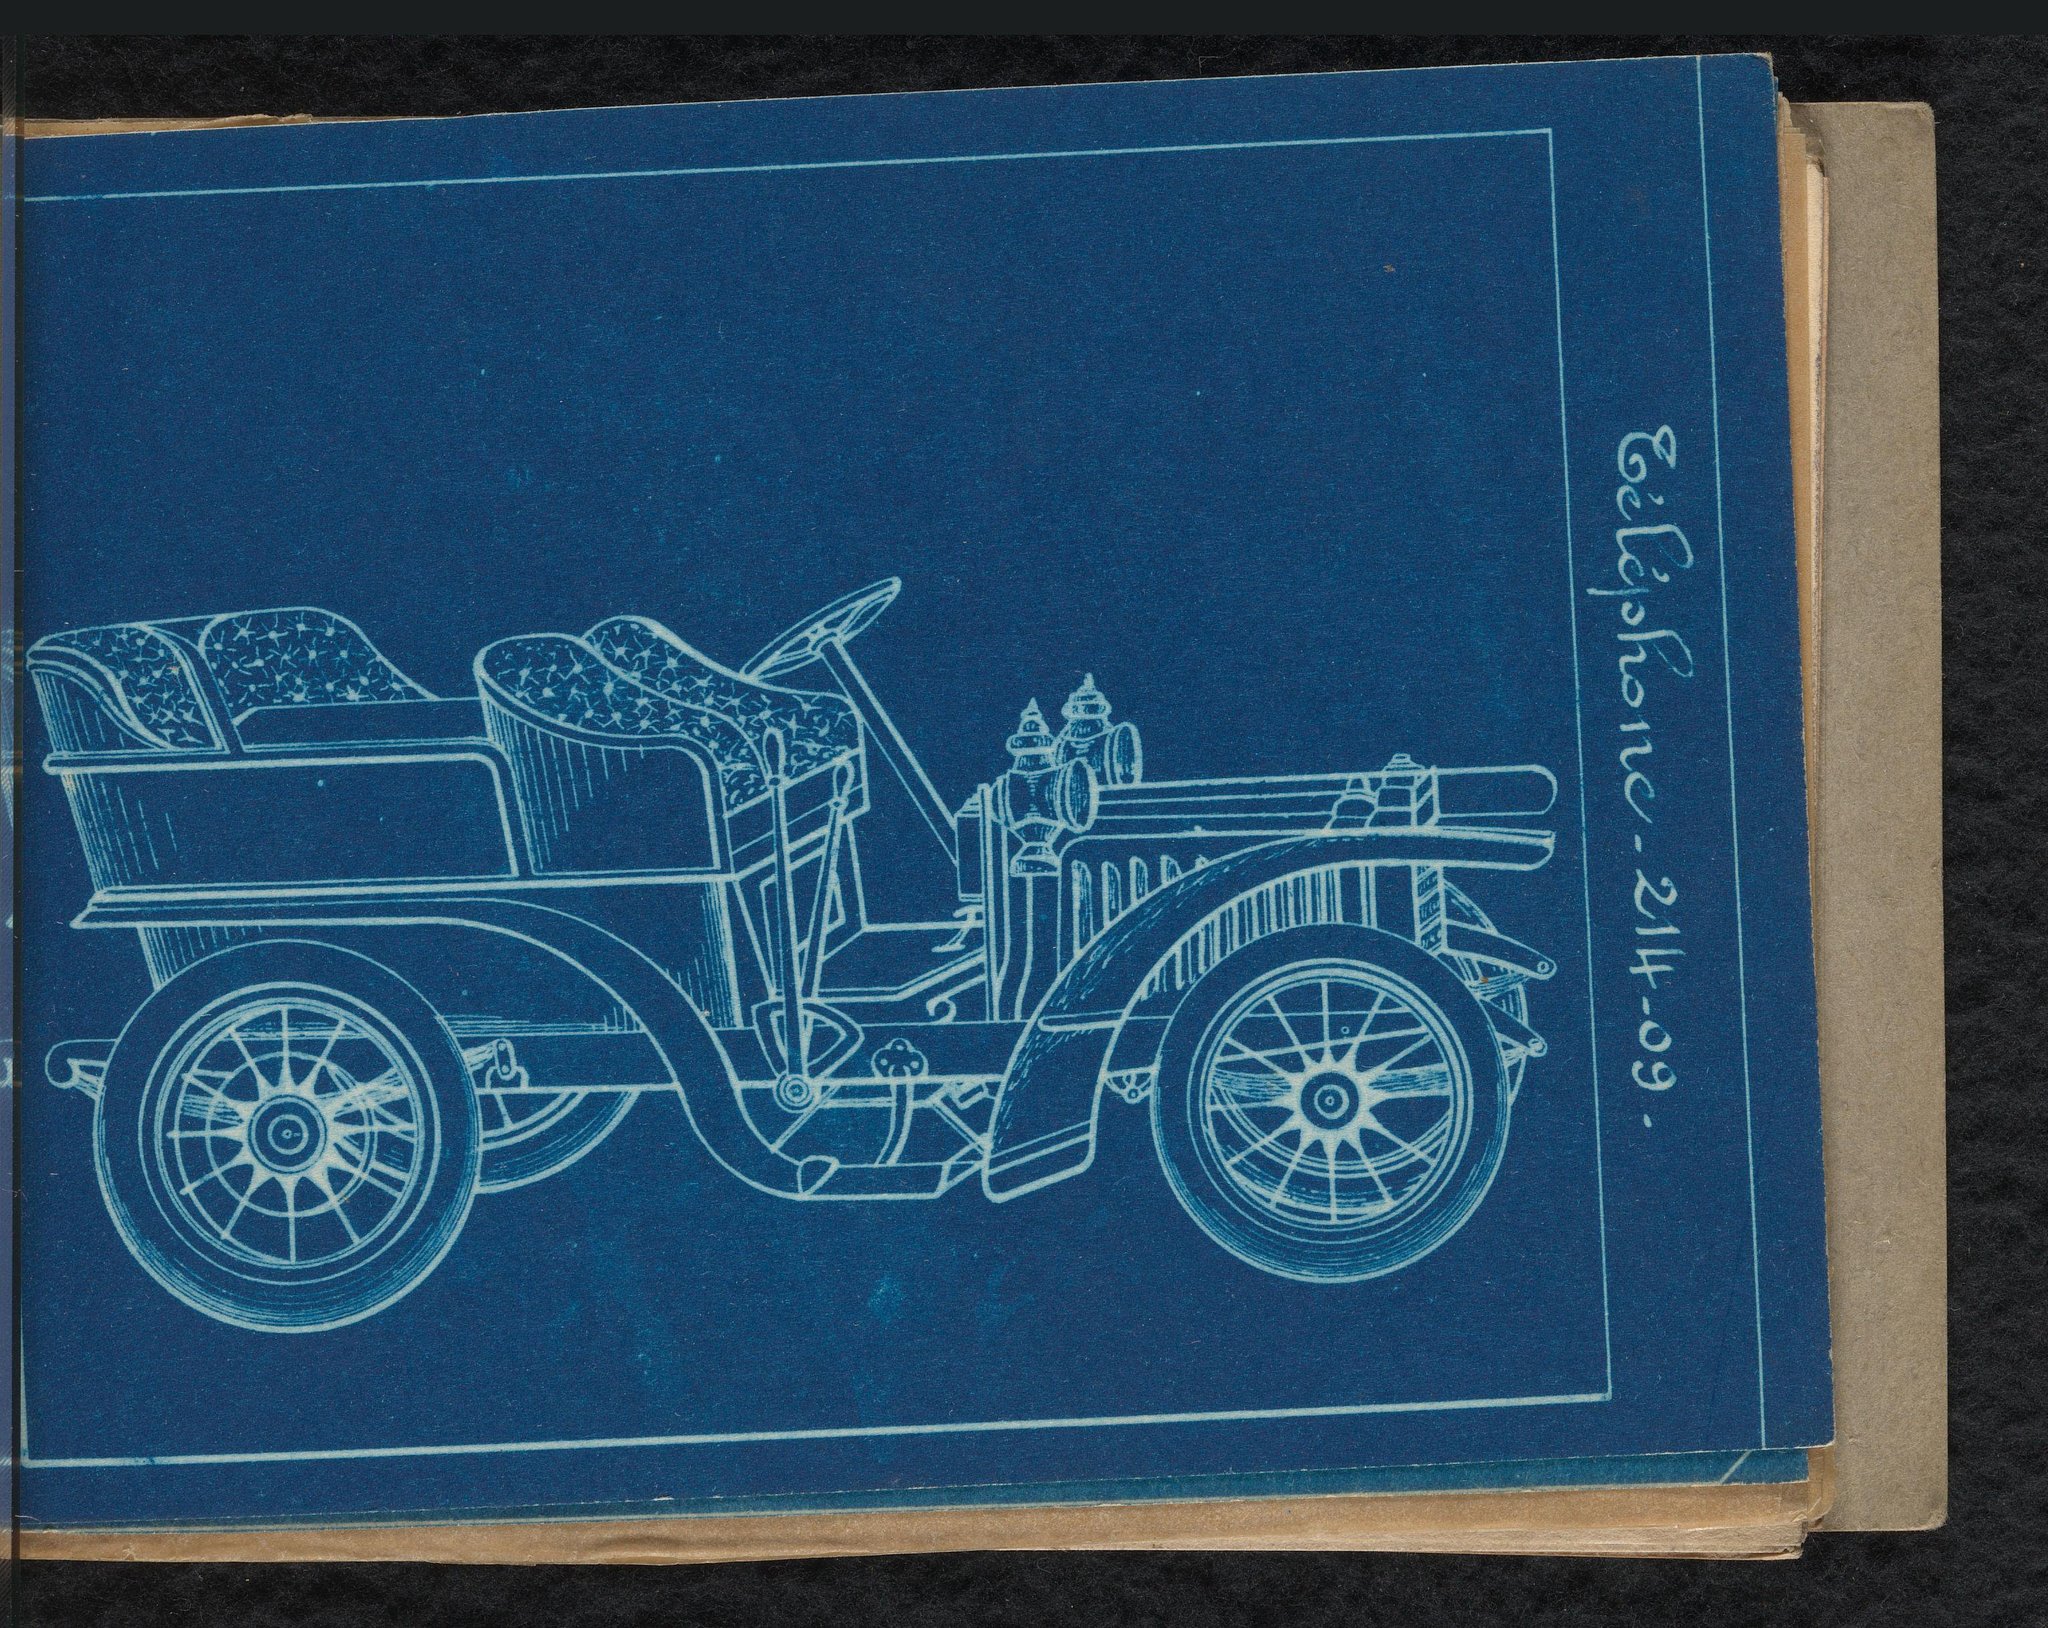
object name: page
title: Fotoreproductie van een tekening van een auto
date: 1905-1910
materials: paper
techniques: cyanotype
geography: paris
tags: drawing (industrial process), automobile, paris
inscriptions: inscription: ‘Ferro EXTRA RAPIDE No 300 / Mêmes prix que le No 30’, inscription: ‘Téléphone - 214-09.’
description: Foto op derde ongenummerde pagina na voorplat.